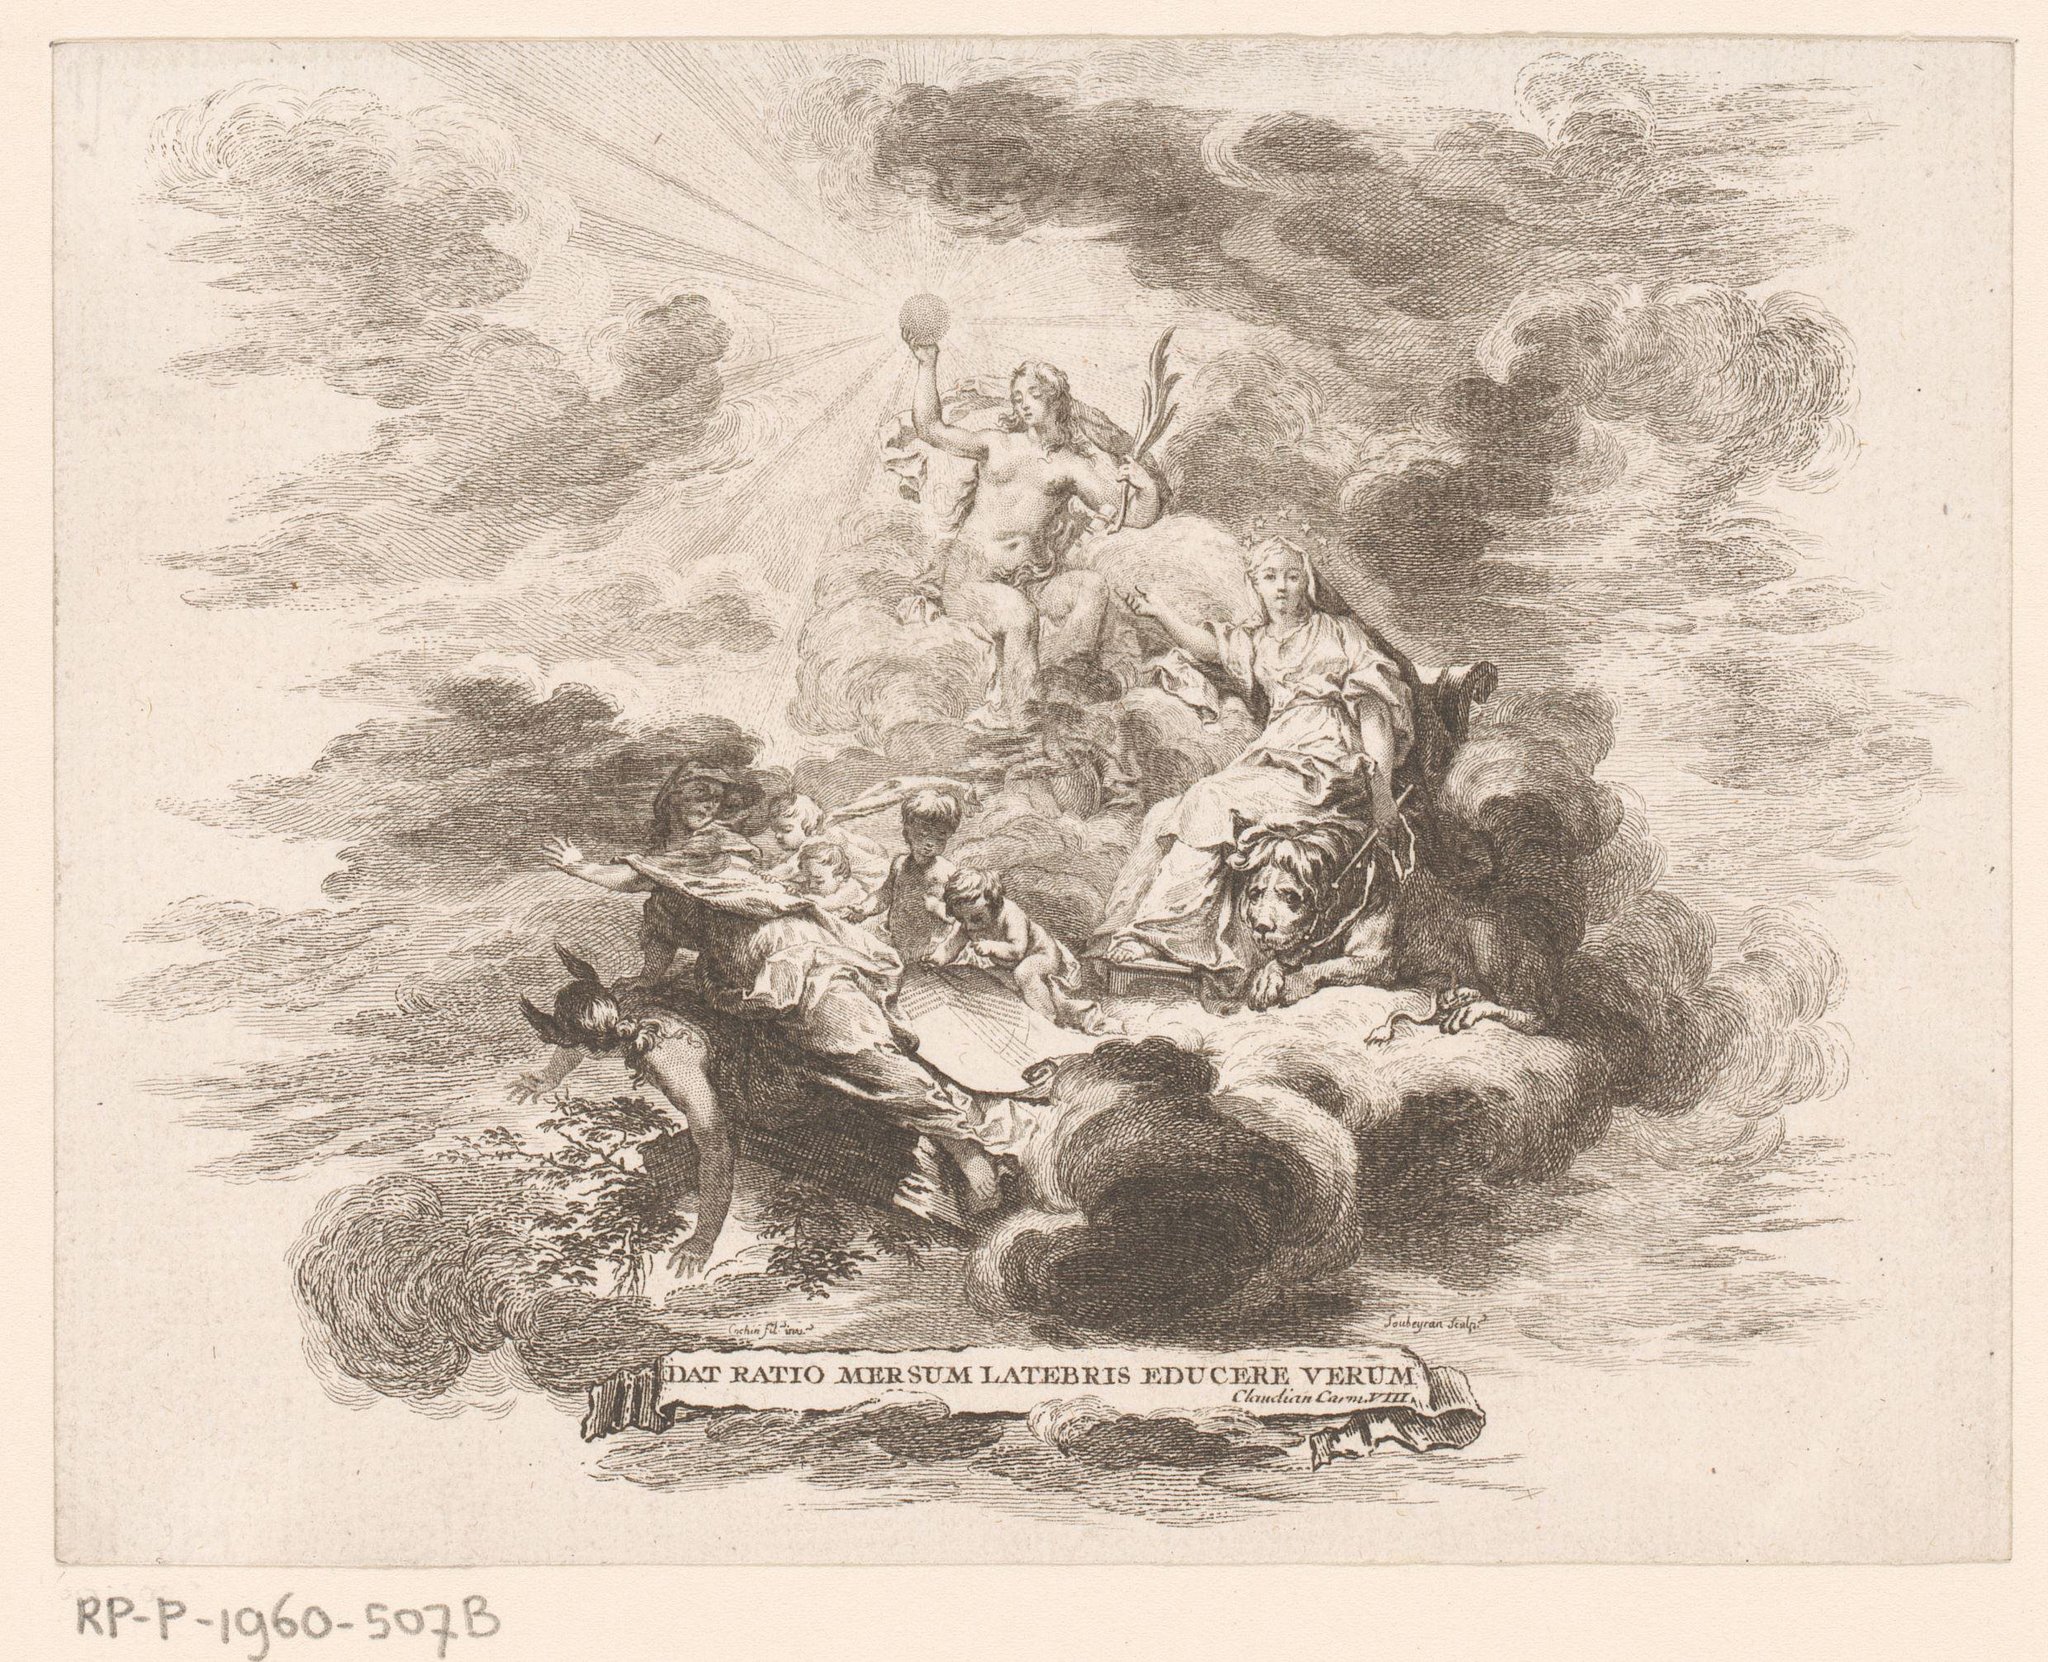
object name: print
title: Allegorie met diverse figuren waaronder de muze Urania en de Waarheid die het licht van de zon over alles laat schijnen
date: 1748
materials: paper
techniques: engraving, etching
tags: calumny of apelles: bad judge with ass's ears on throne, with deceit, envy, ignorance, suspicion and treachery, confronted with innocent accused; remorse and truth present, 'astronomia' (~ quadrivium); 'astronomia' (ripa), truth; 'verità' (ripa), urania (one of the muses); 'urania' (ripa), beasts of prey, predatory animals: lion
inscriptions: collector's mark: Lugt 2228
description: Prent uit: Puységur, François-Jacques de Chastenet. Art de la guerre par principes et par règles […]. Parijs: Charles-Antoine Jombert, 1748.